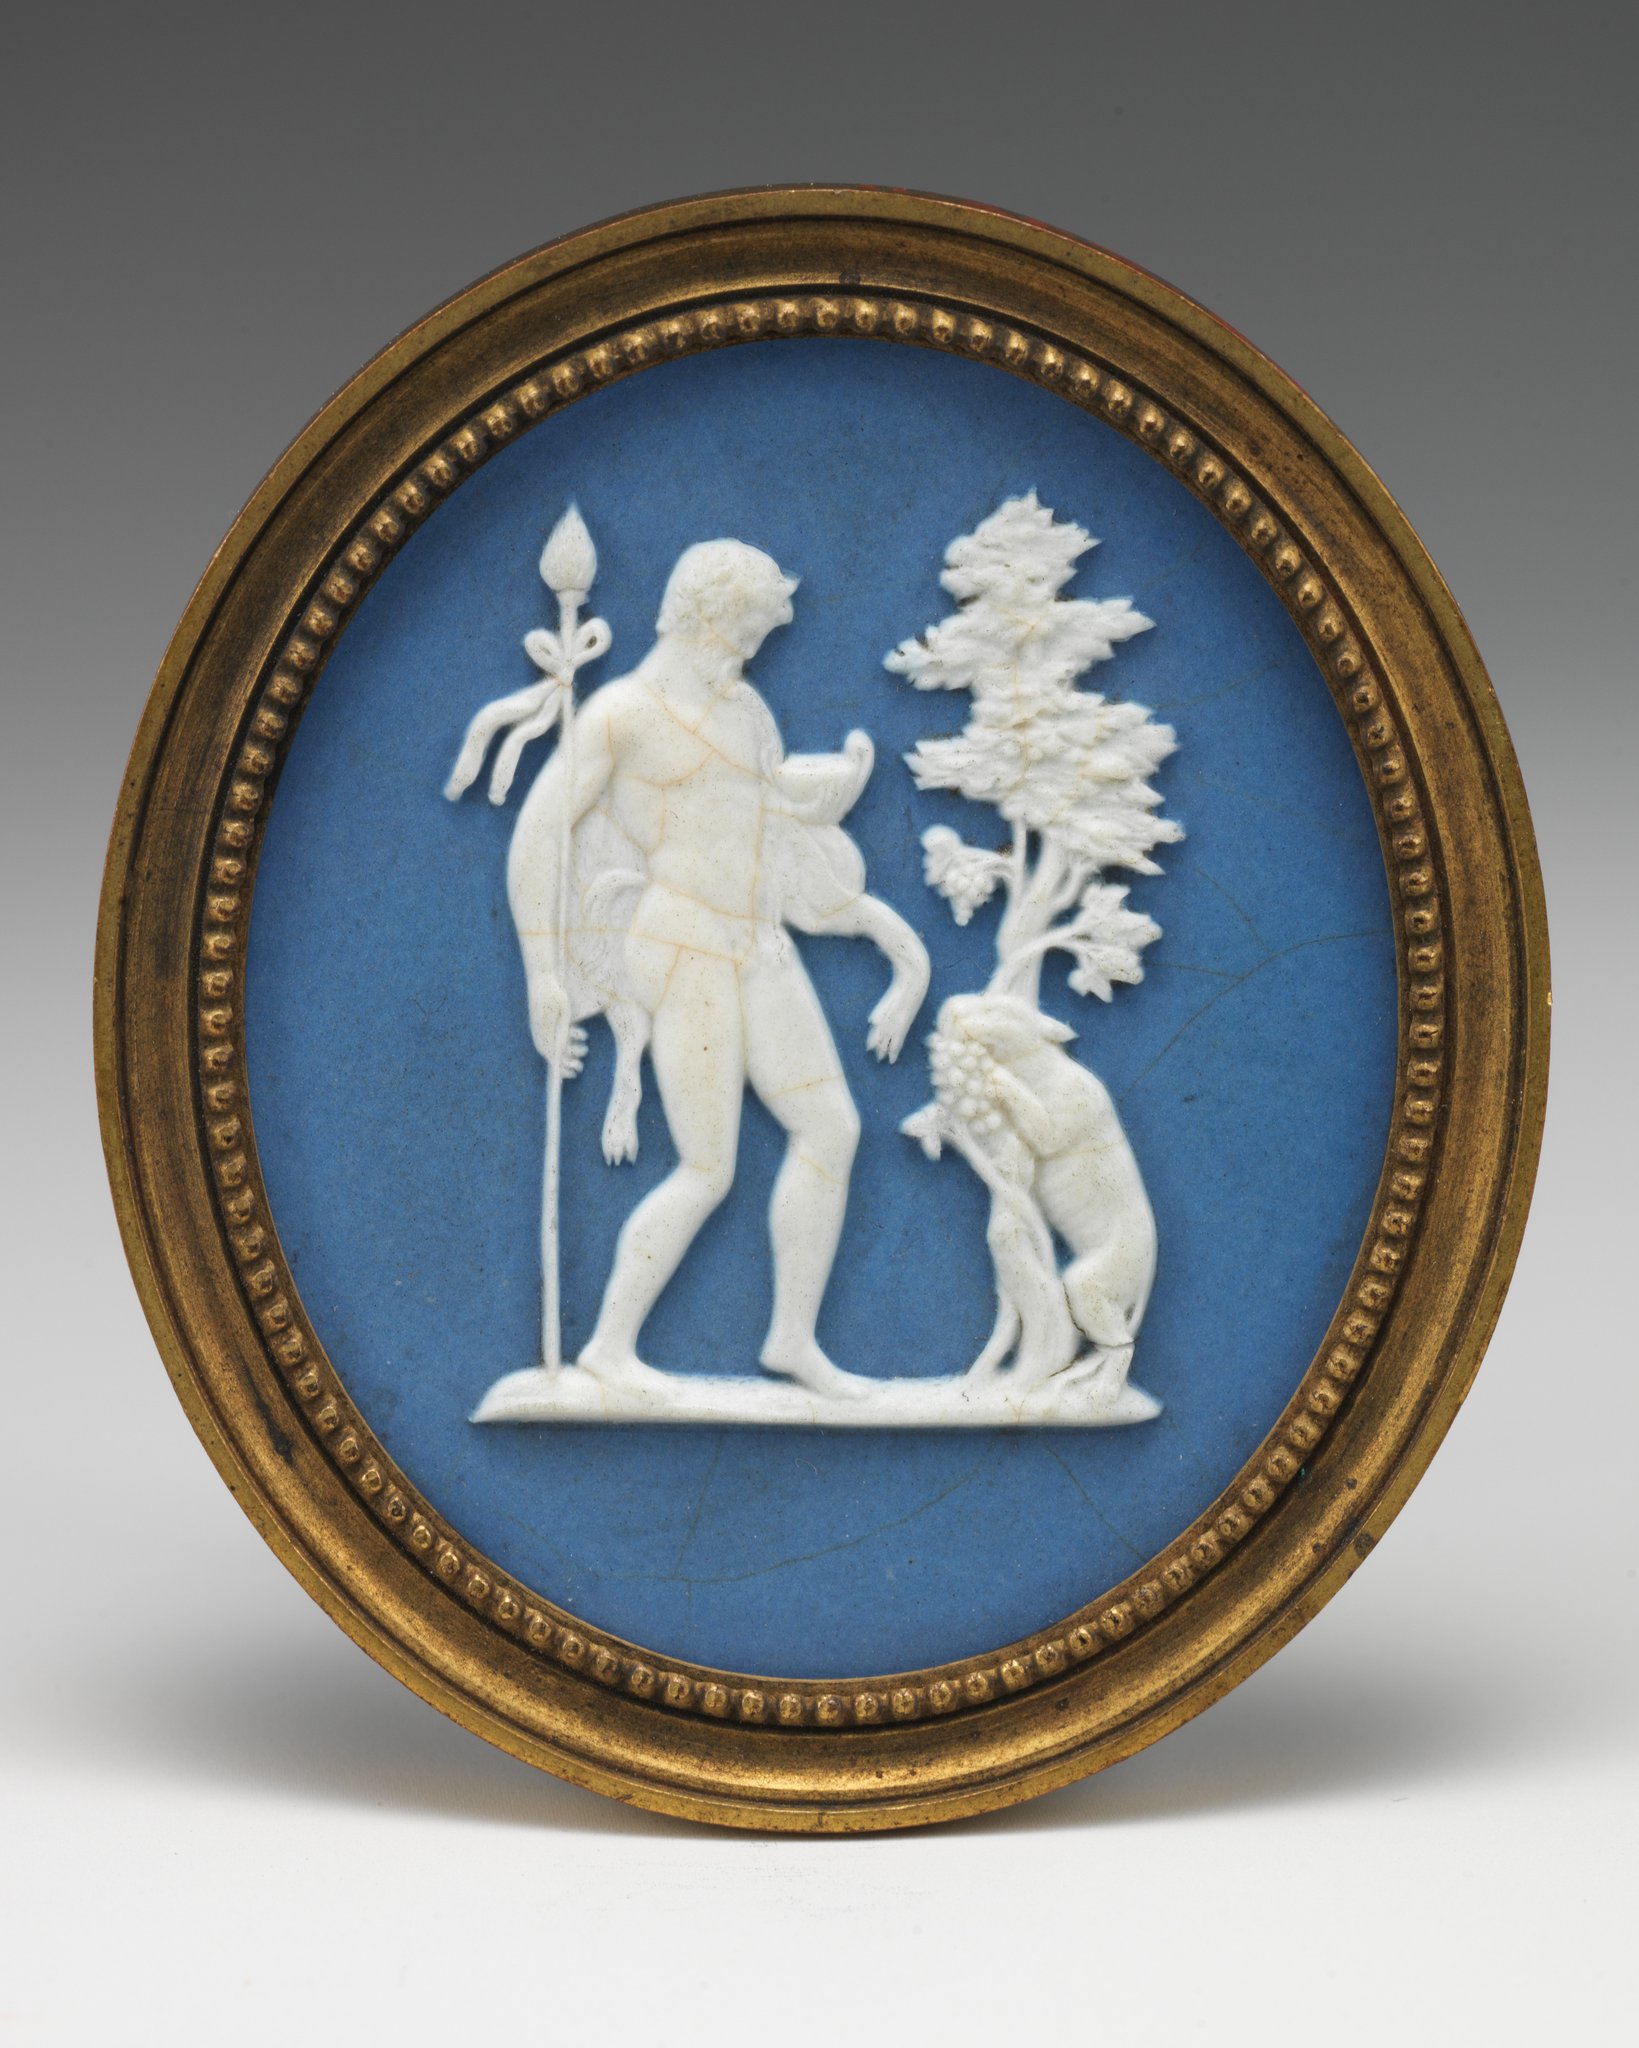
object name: cameo medallion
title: Satyr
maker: wedgwood and bentley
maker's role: maker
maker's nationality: british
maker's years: 1769-1780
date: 1769-1780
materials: jasper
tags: satyrs,trees